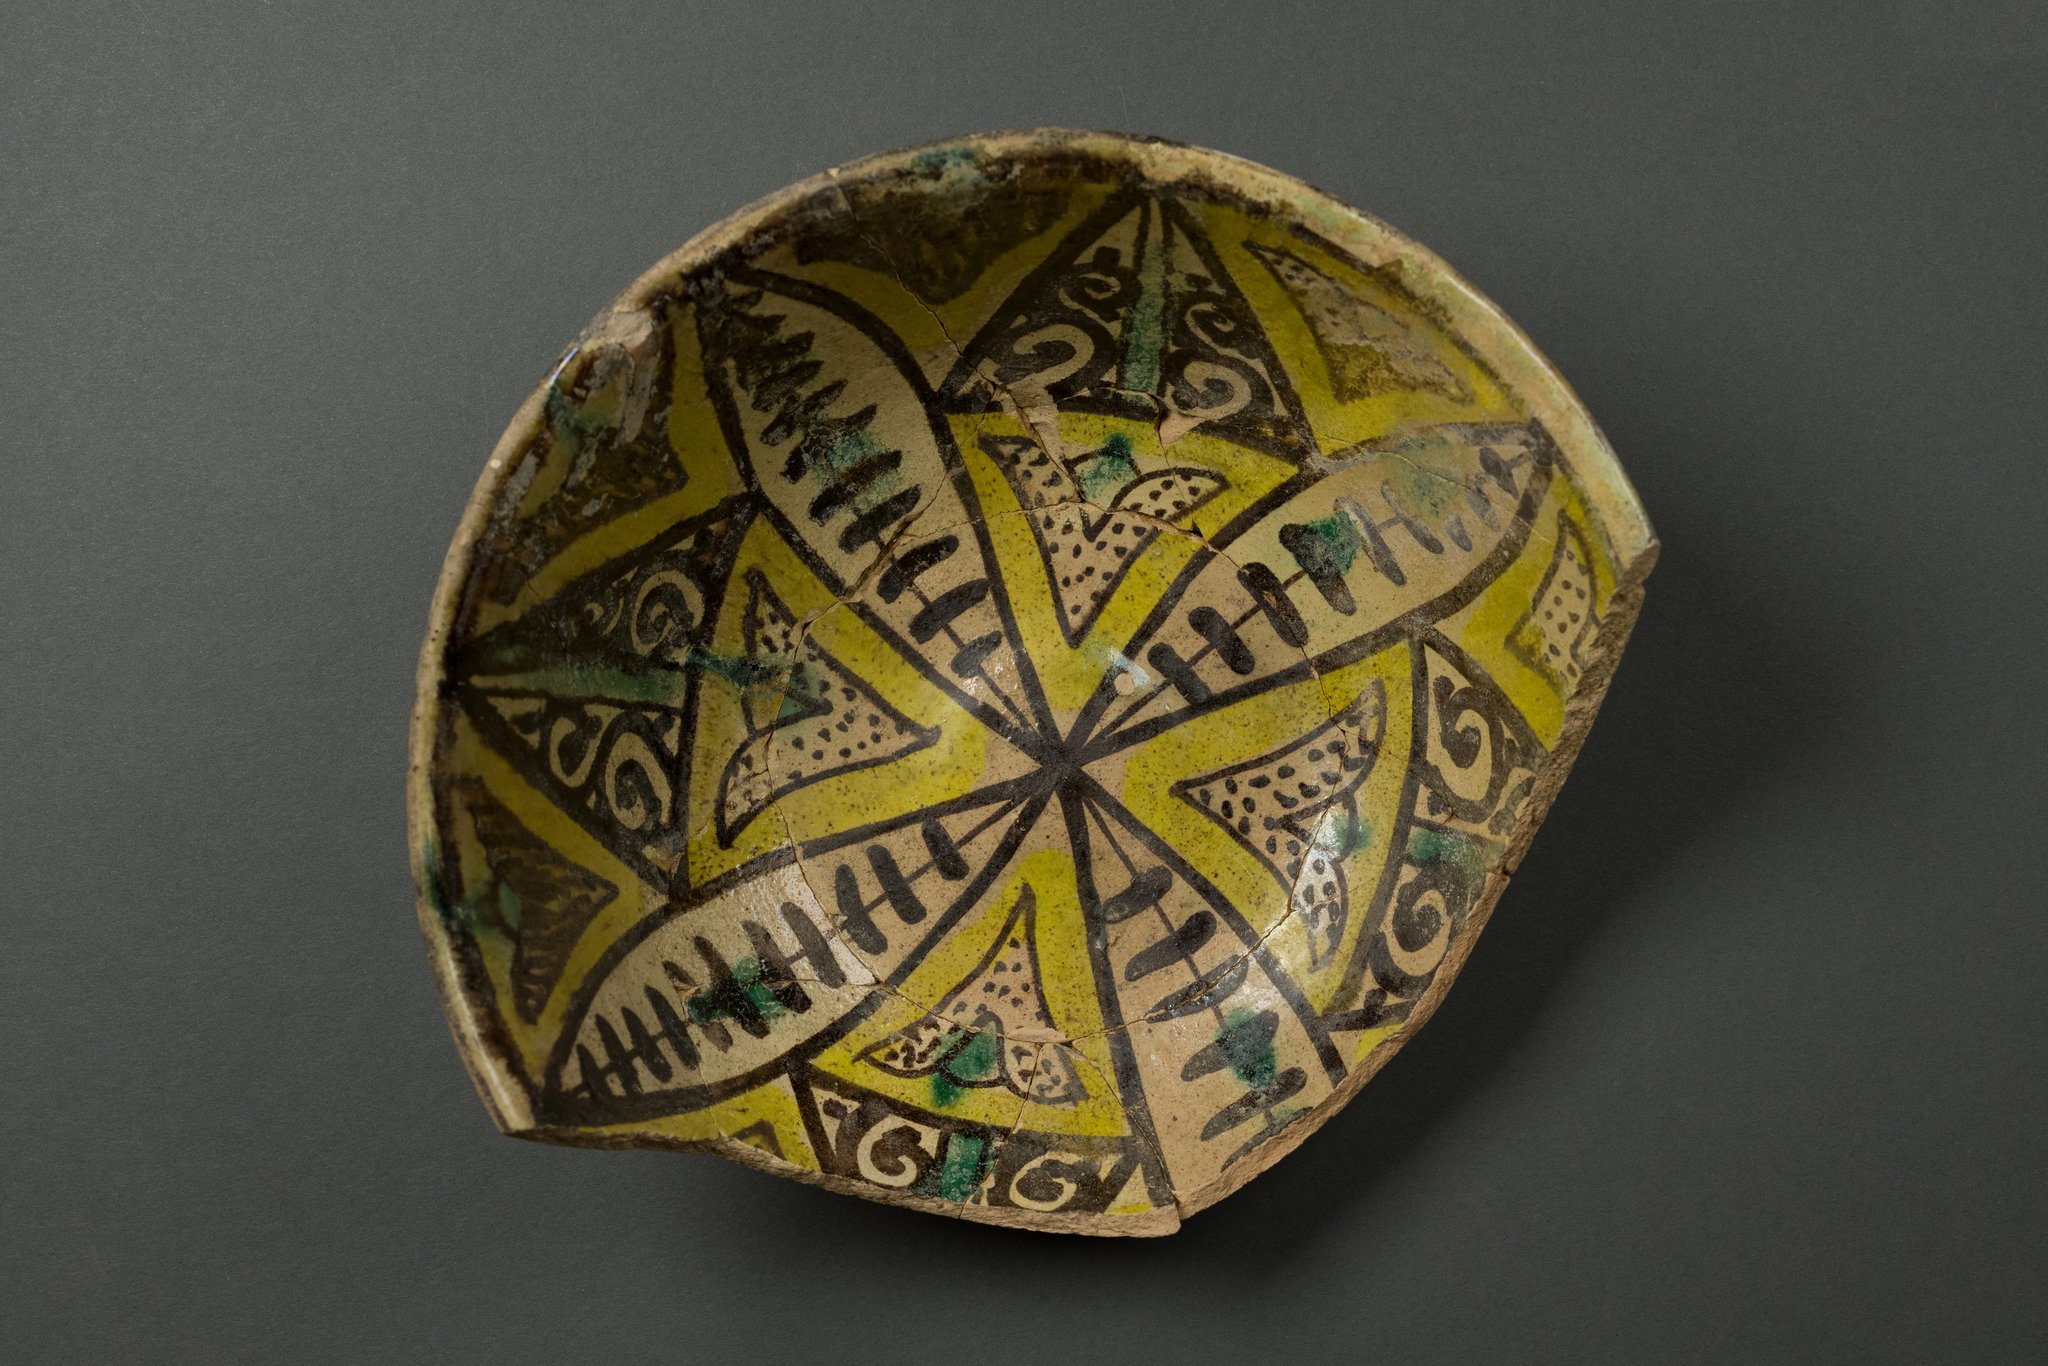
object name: bowl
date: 801-900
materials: earthenware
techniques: glazing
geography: iran